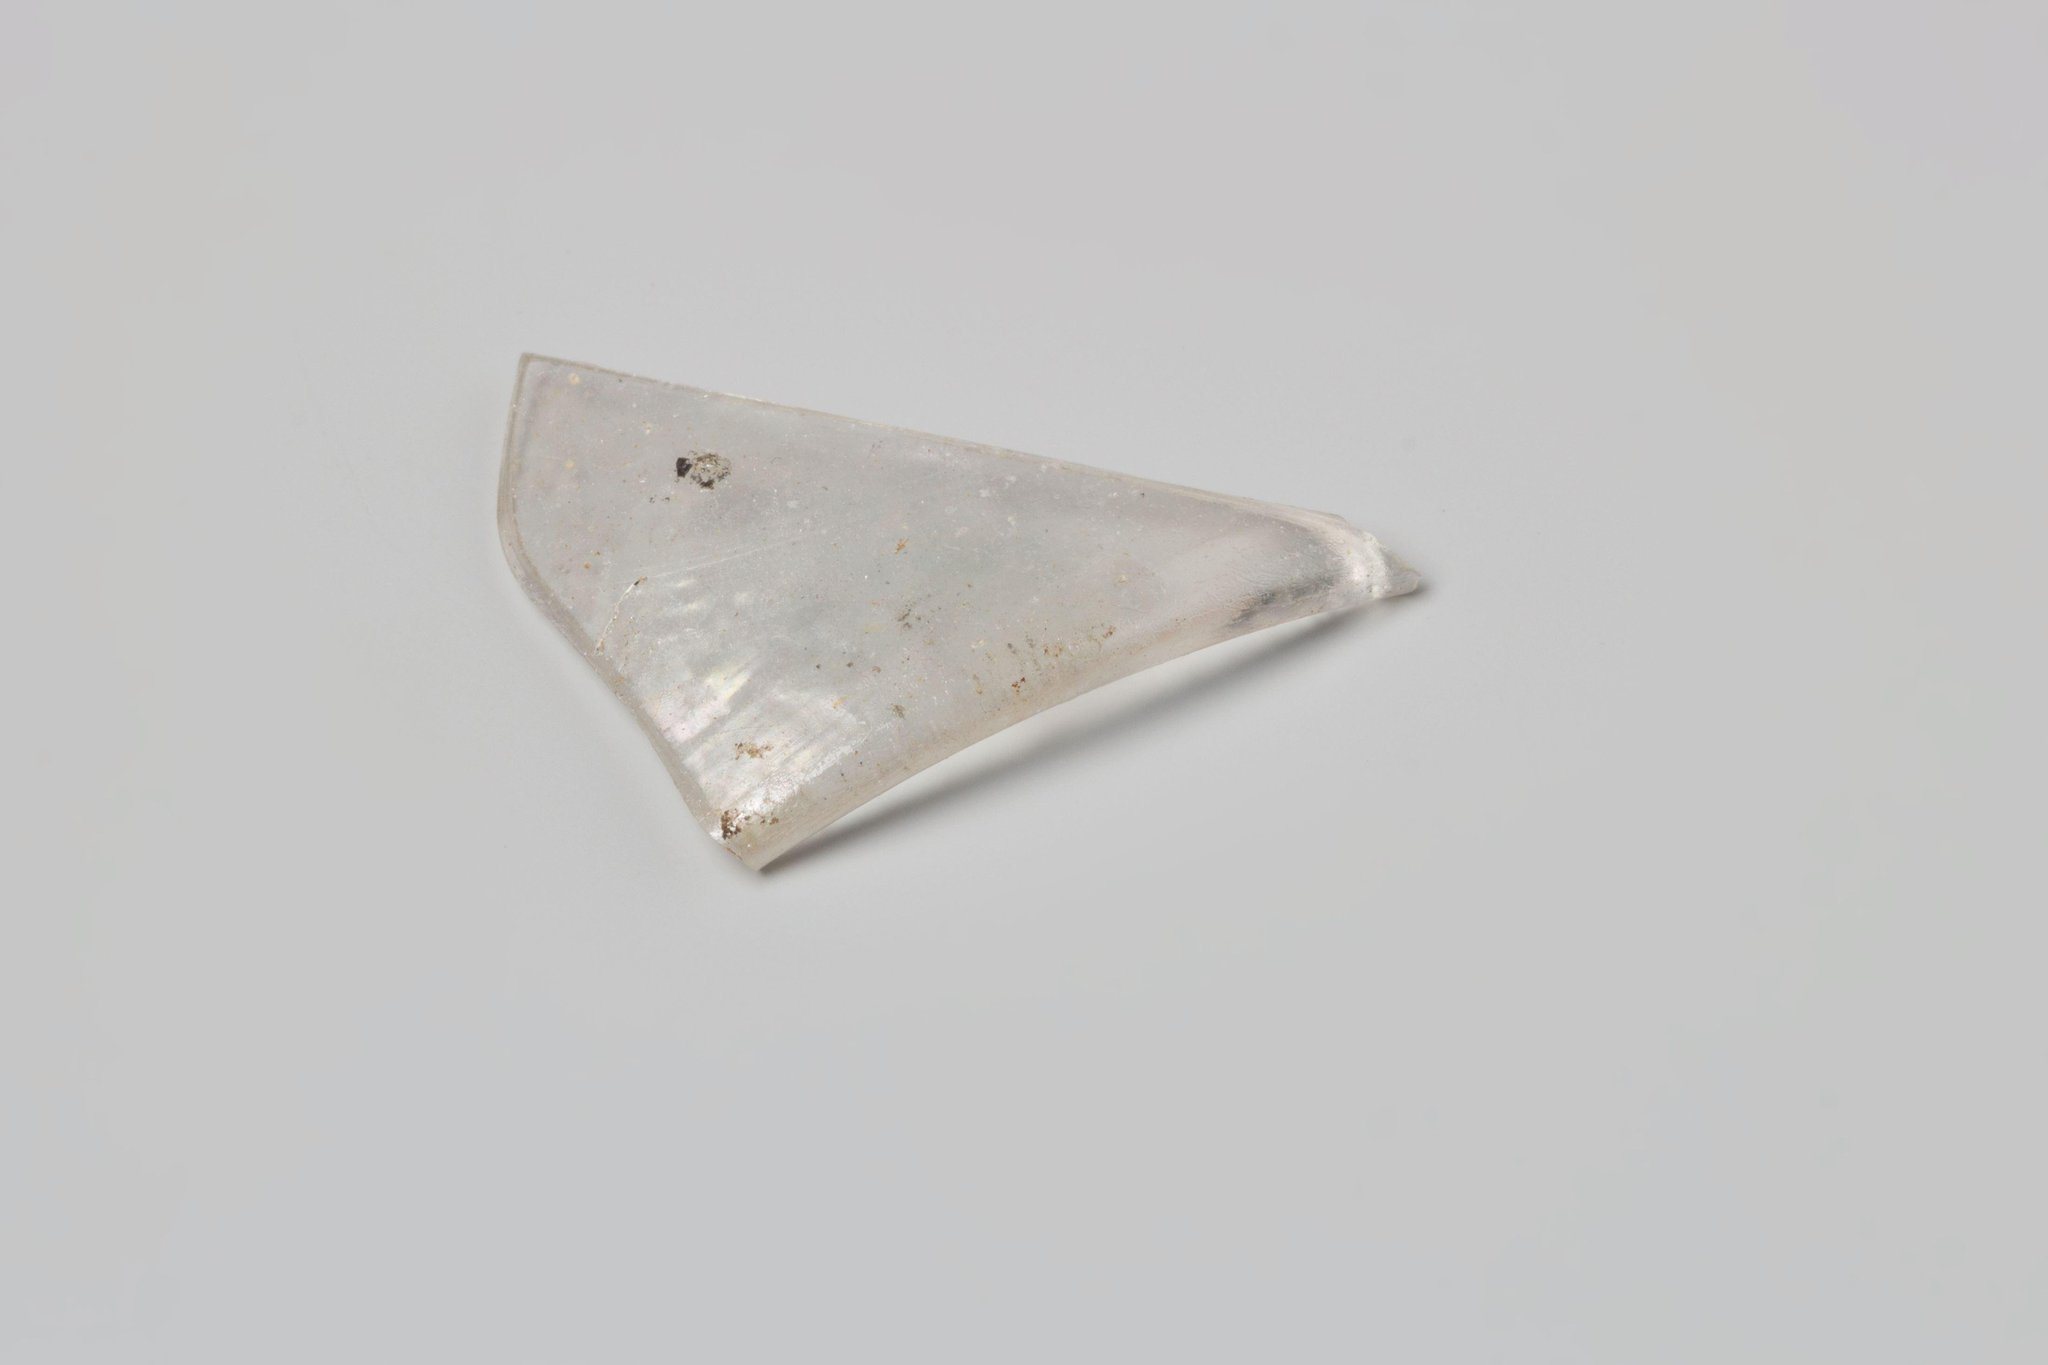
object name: wine goblet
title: Glasscherf van een wijnglas uit het wrak van de in 1735 vergane Oost-Indiëvaarder 't Vliegend Hart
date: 1700-1735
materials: glass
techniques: manufacturing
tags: 't vliegend hart (schip), verenigde oostindische compagnie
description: Het dunne glasfragment is doorschijnend en transparant. Het is een randfragment en vermoedelijk maakte het onderdeel uit van een wijnglas. Wineglass.ansparant